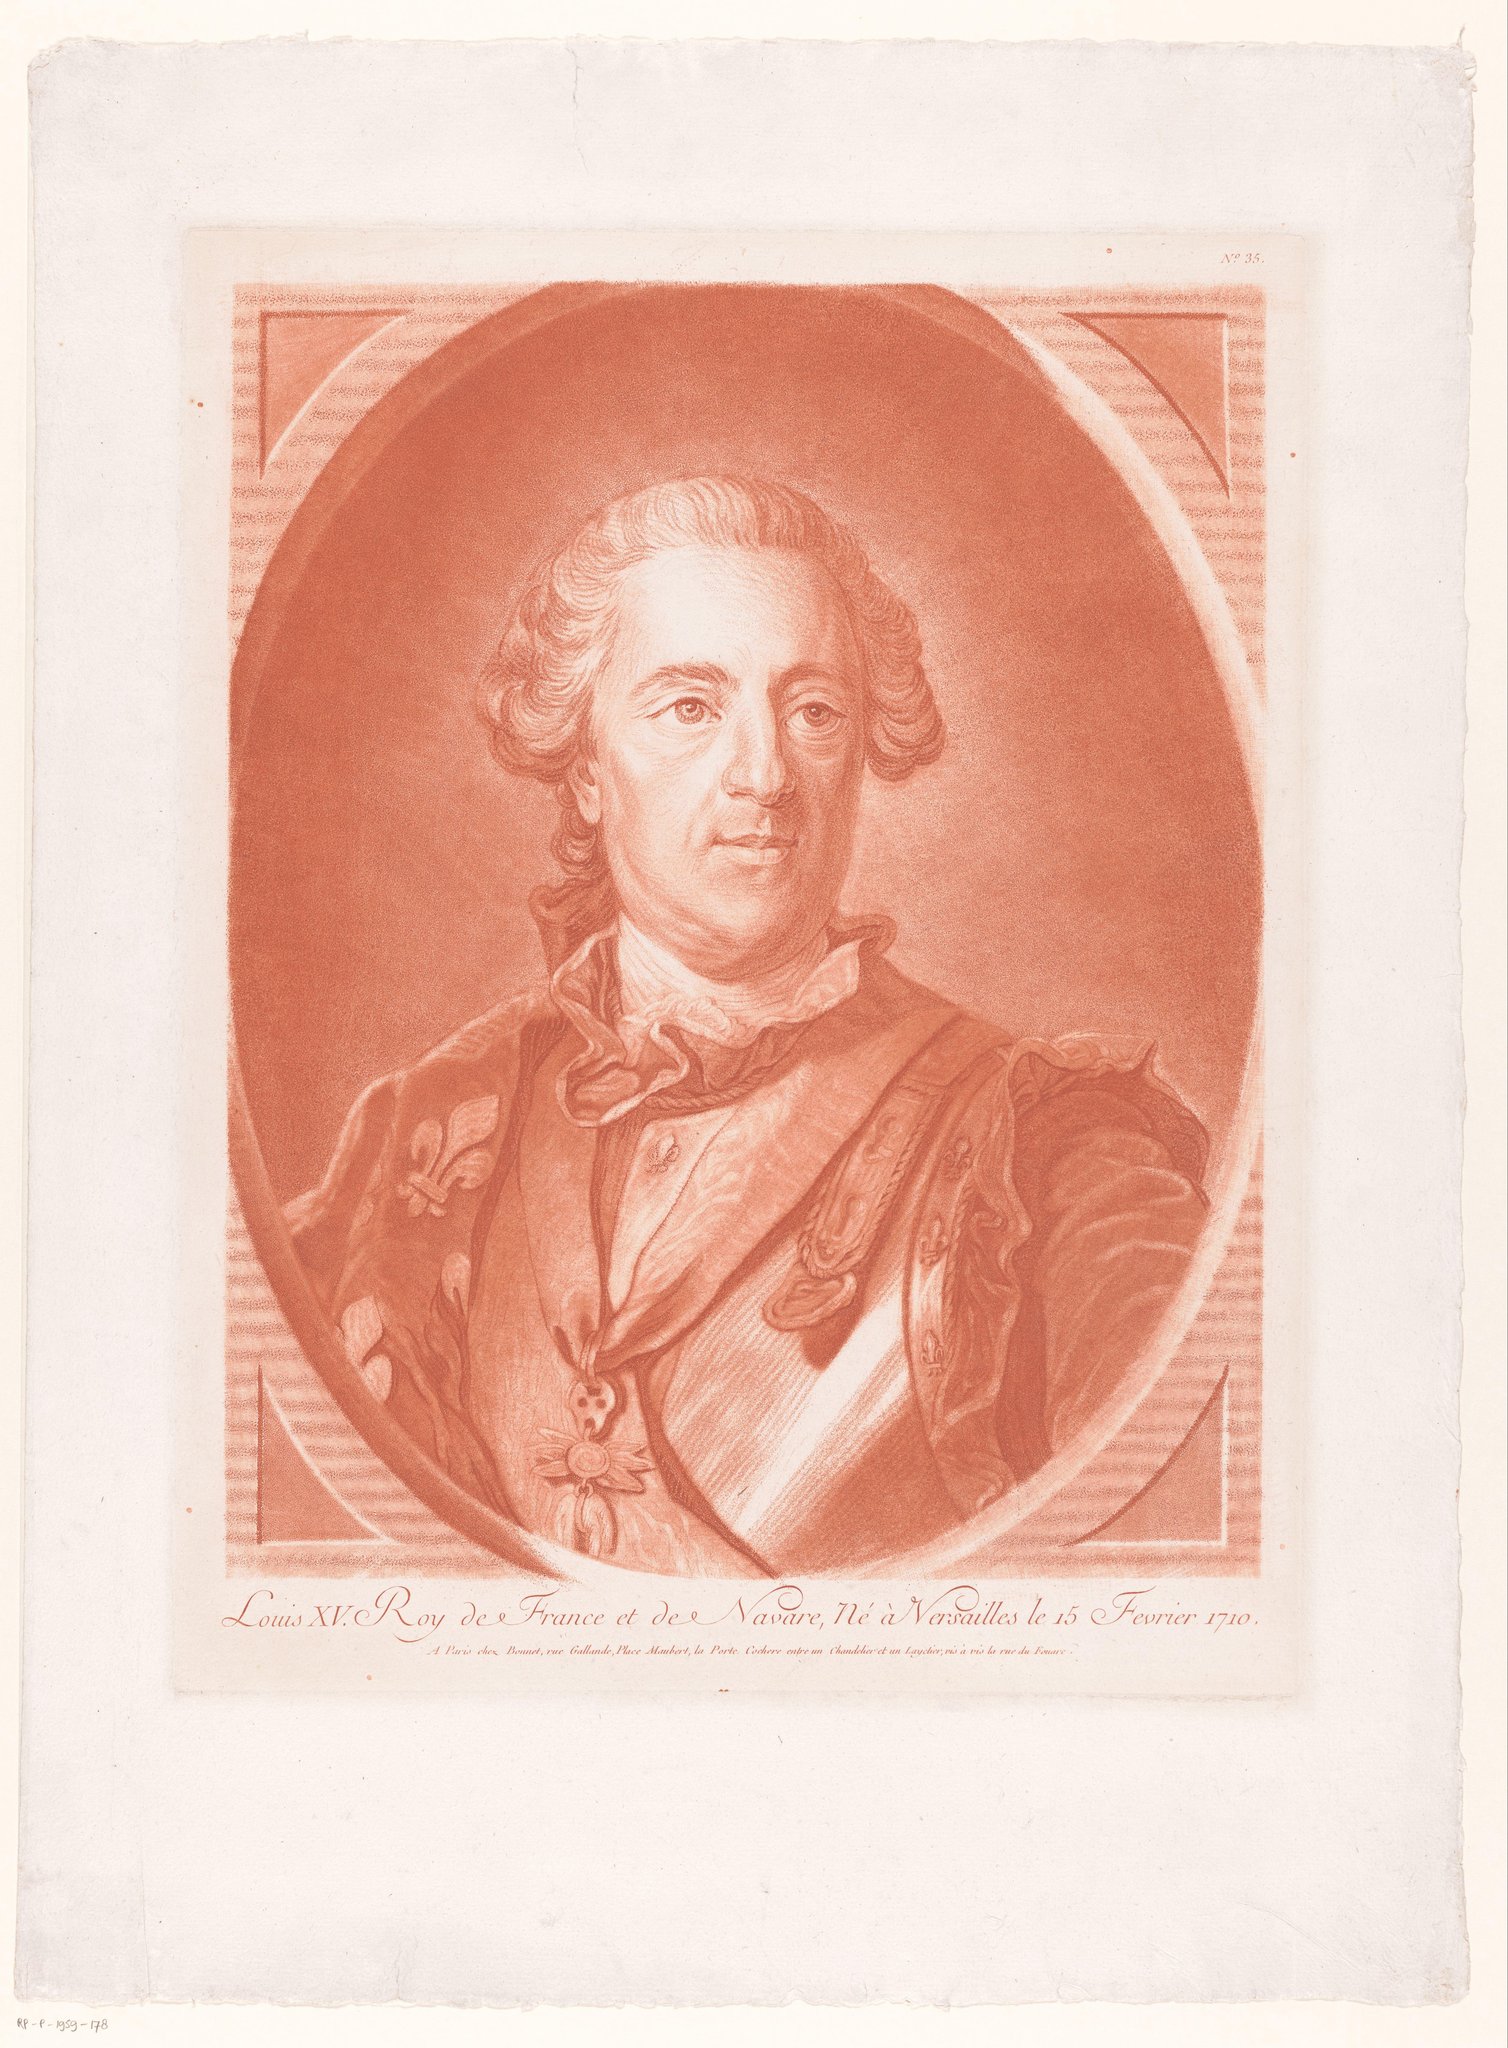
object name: print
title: Portret van Lodewijk XV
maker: louis marin bonnet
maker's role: print maker, publisher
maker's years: 1736-1793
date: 1770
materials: paper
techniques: printmaking, engraving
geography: paris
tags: louis xv of france, historical persons, king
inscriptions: collector's mark: Lugt 2228, collector's mark: Lugt 2760